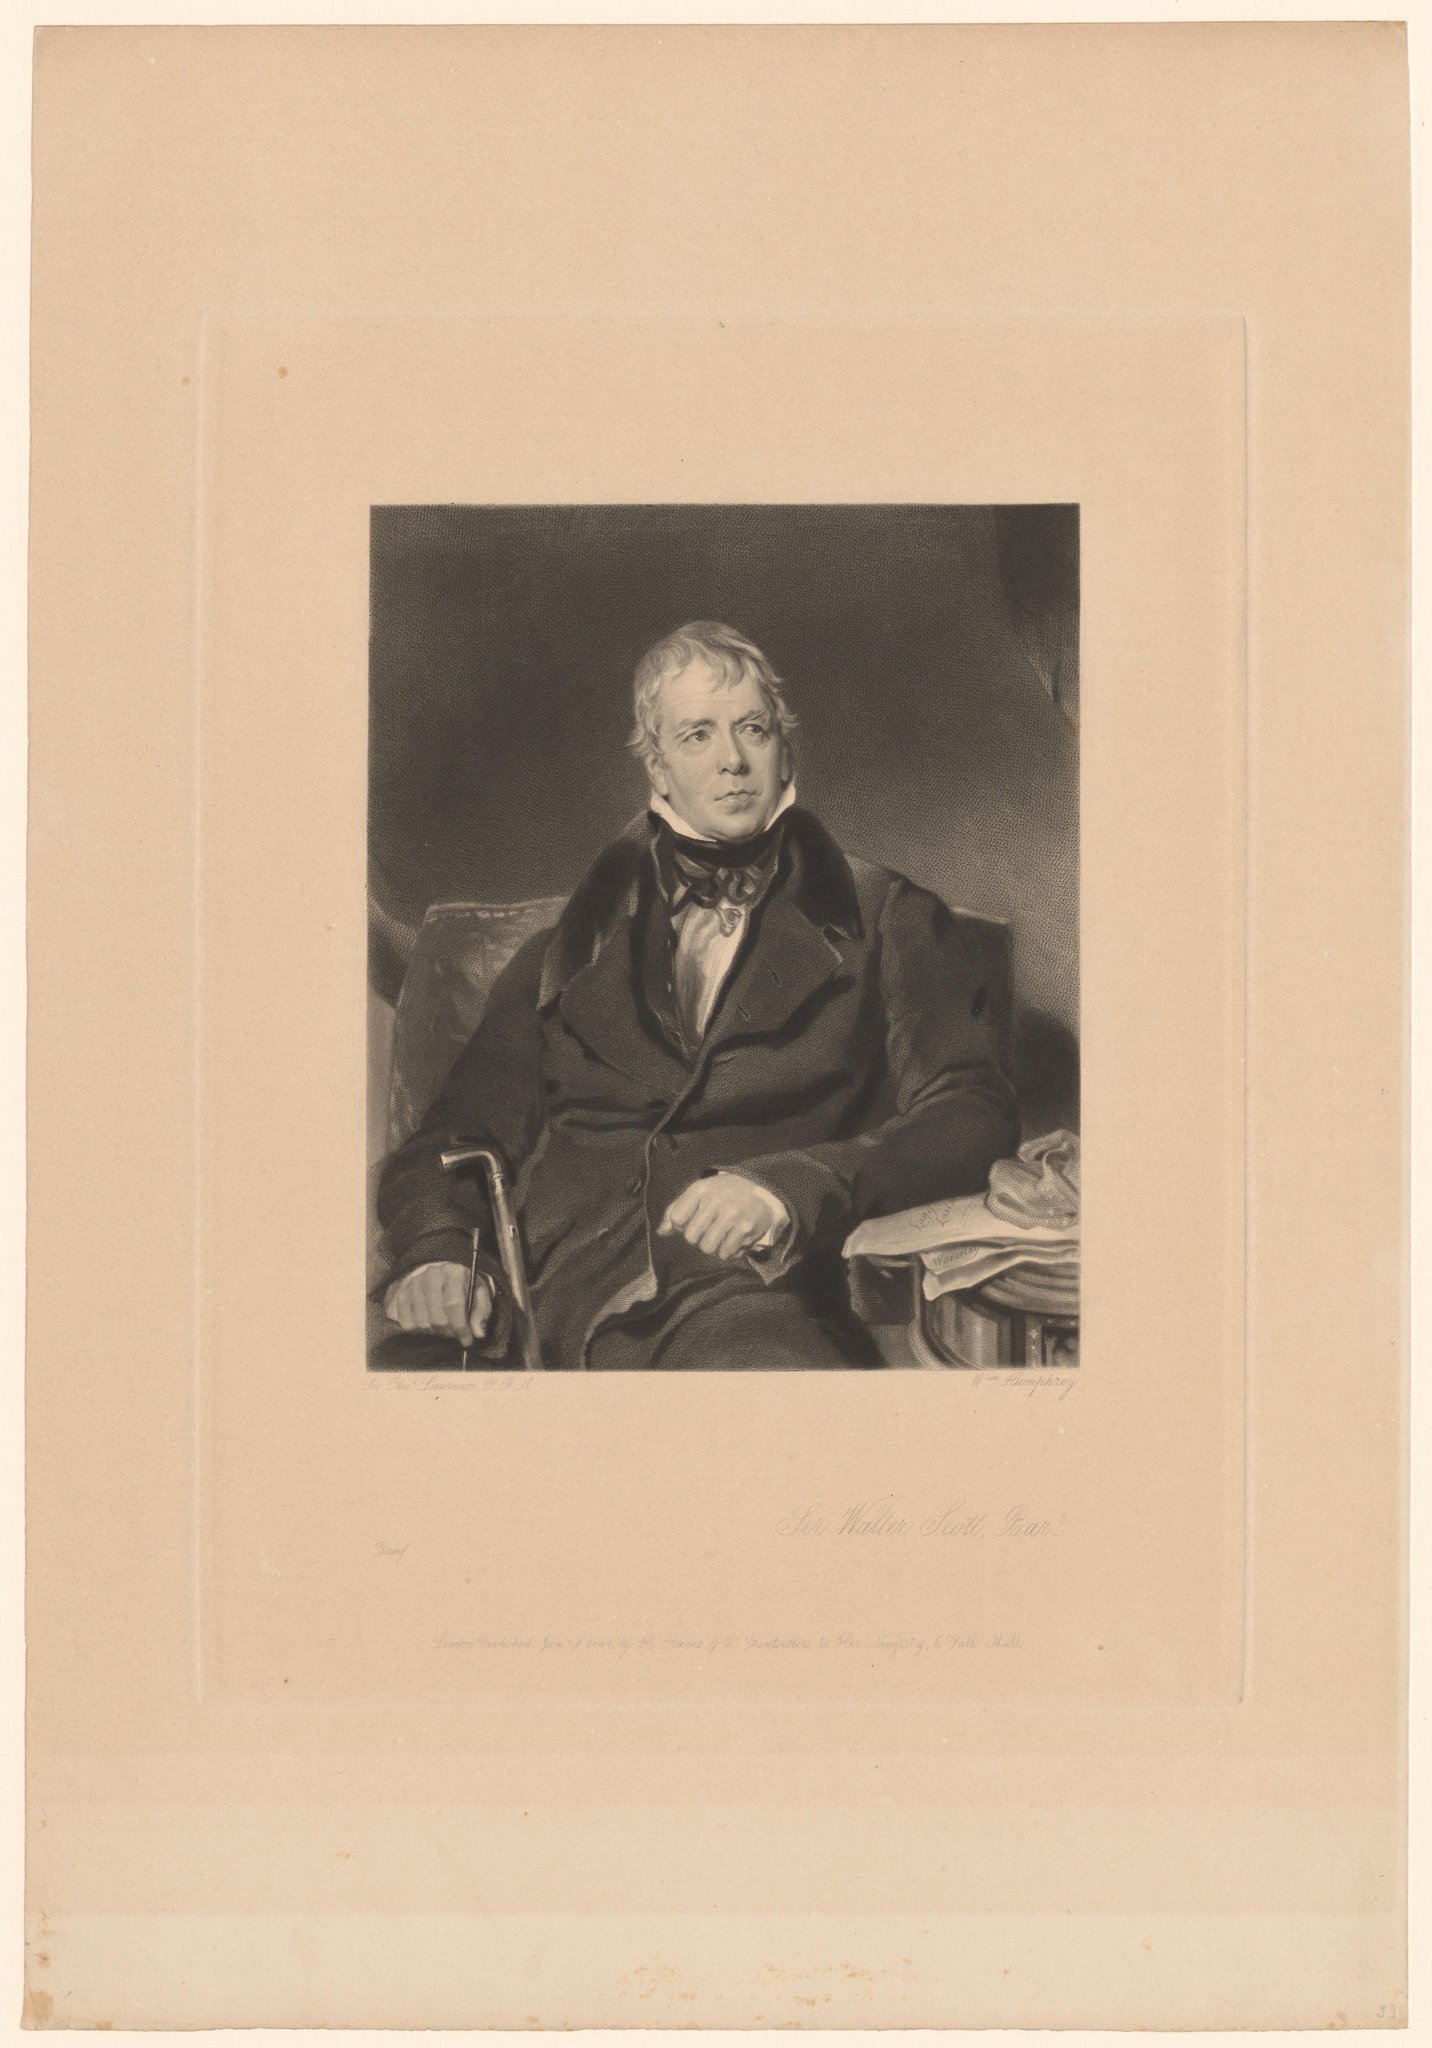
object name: print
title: Portret van Walter Scott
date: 1844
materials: paper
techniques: engraving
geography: london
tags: walter scott, historical persons, portrait of a writer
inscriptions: collector's mark: Lugt 2228